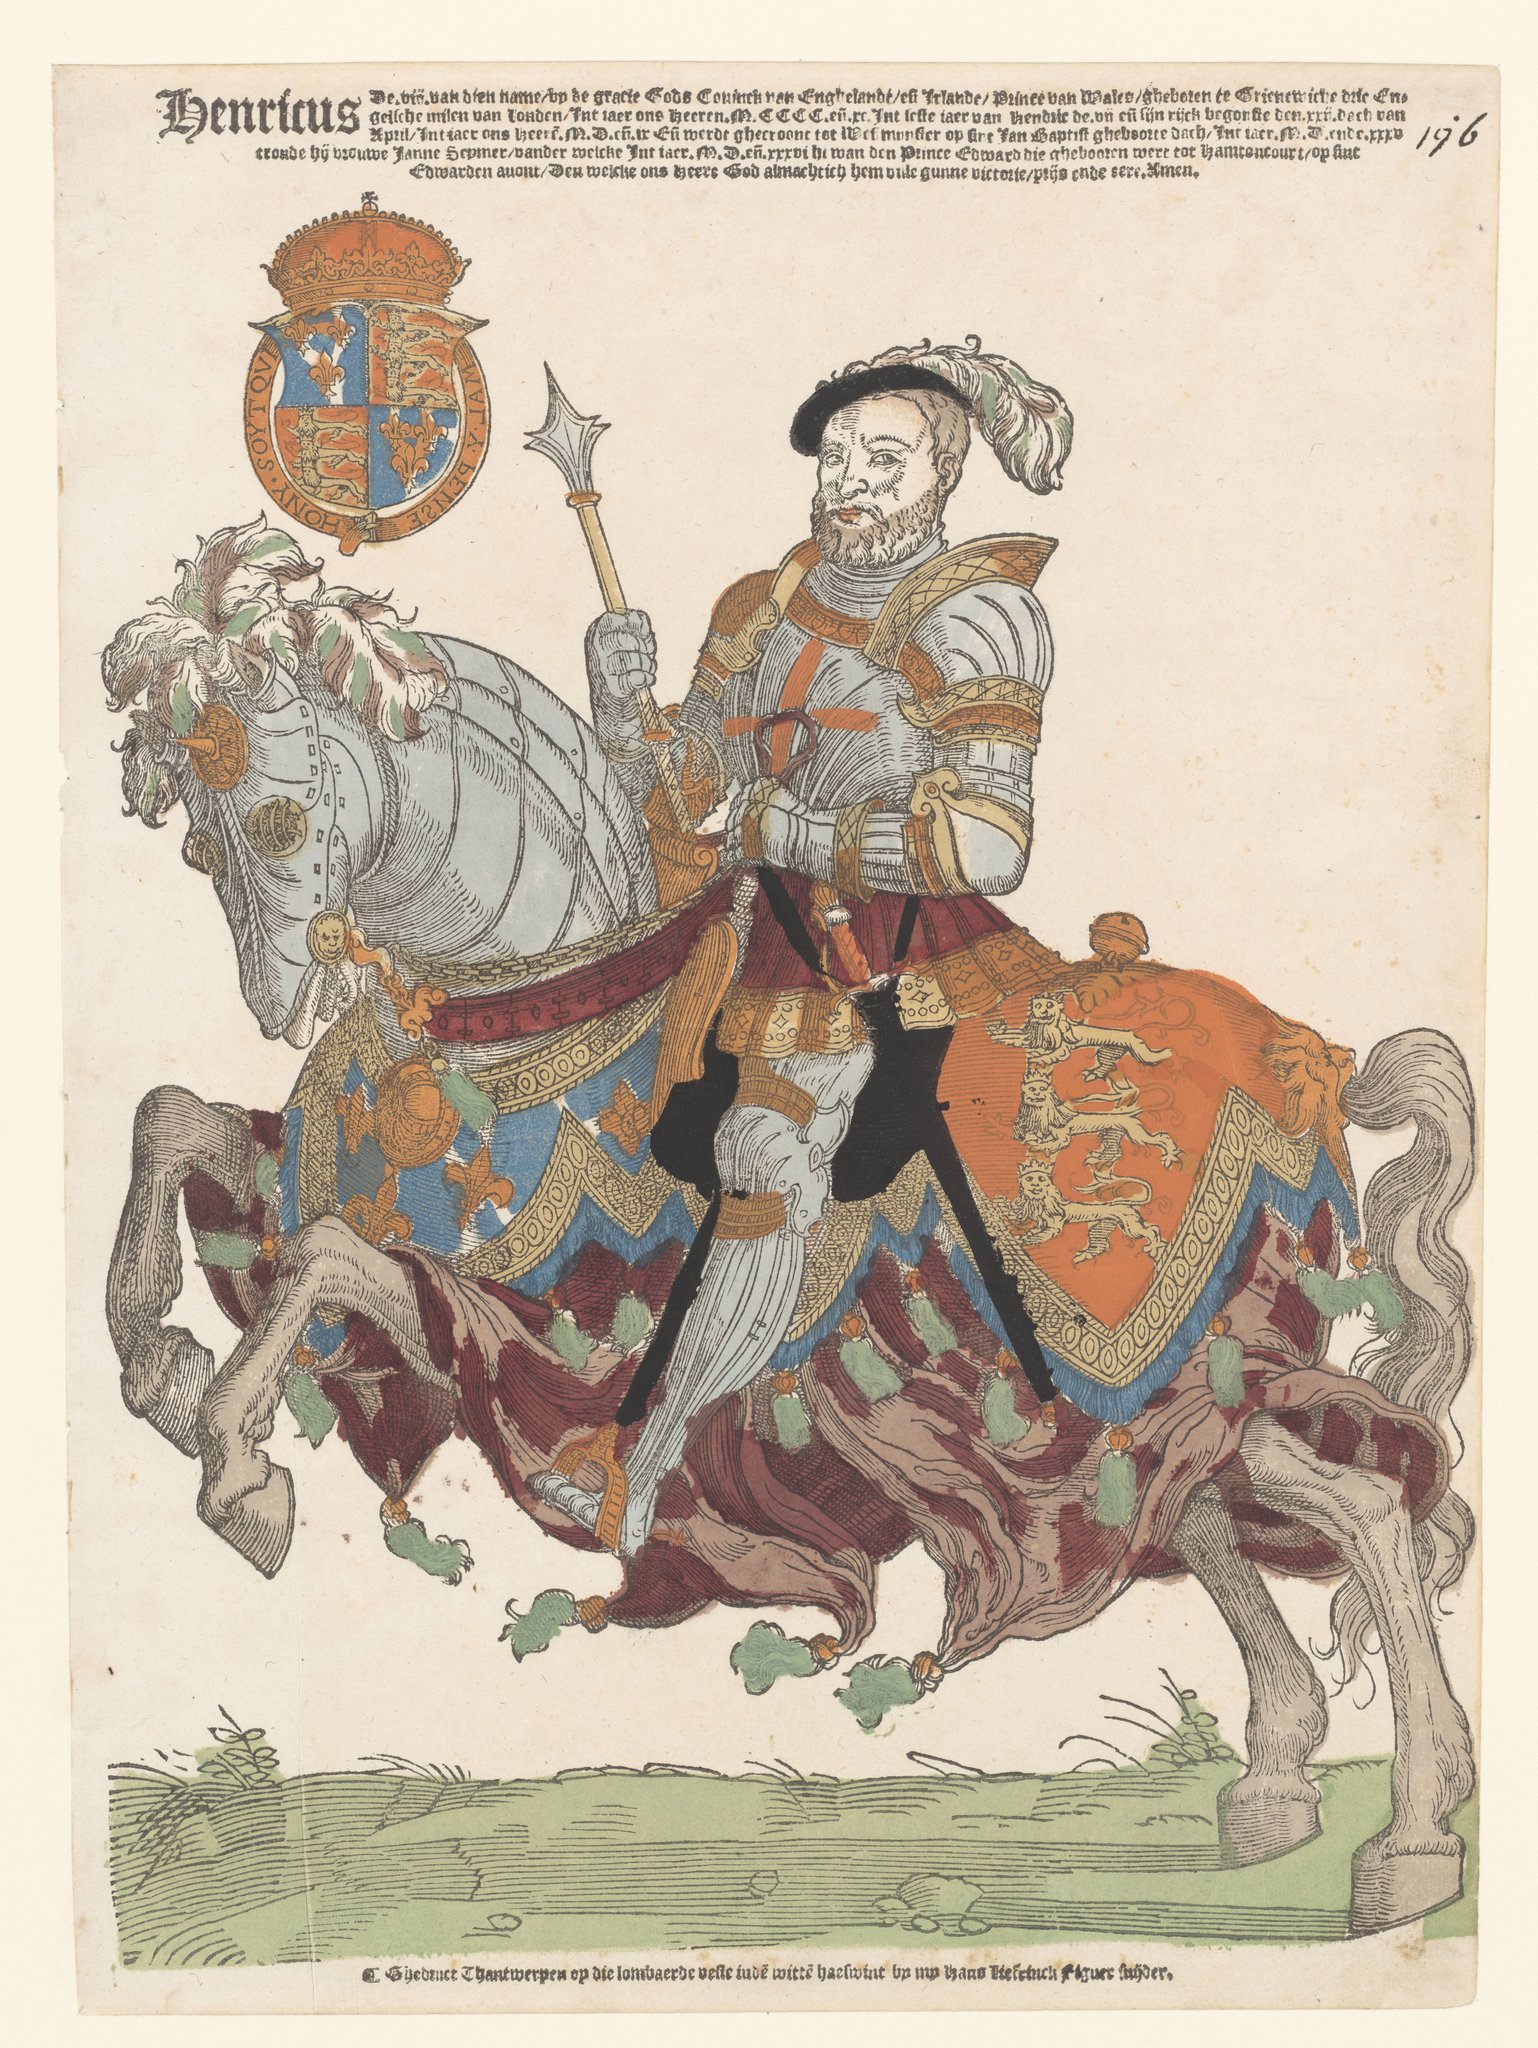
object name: print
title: Portret van Hendrik VIII van Engeland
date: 1539-1547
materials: paper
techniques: hand coloring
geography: antwerp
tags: equestrian state-portrait, king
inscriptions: number: ‘196’, address: ‘Gedruckt Thantwerpen op die lombaerde veste in de witte haeswint by my Hans Liefrinck Figuer snijder.’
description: Herdruk VIII te paard in wapenrusting. Het paard draagt een dubbel dekkleed met vliegende kwasten. Het wapen van Engeland met de Orde van de Kousenband linksboven. Vijf regels tekst in het Nederlands boven de ruiter, één eronder. Navolging van Hol 22 door andere hand.